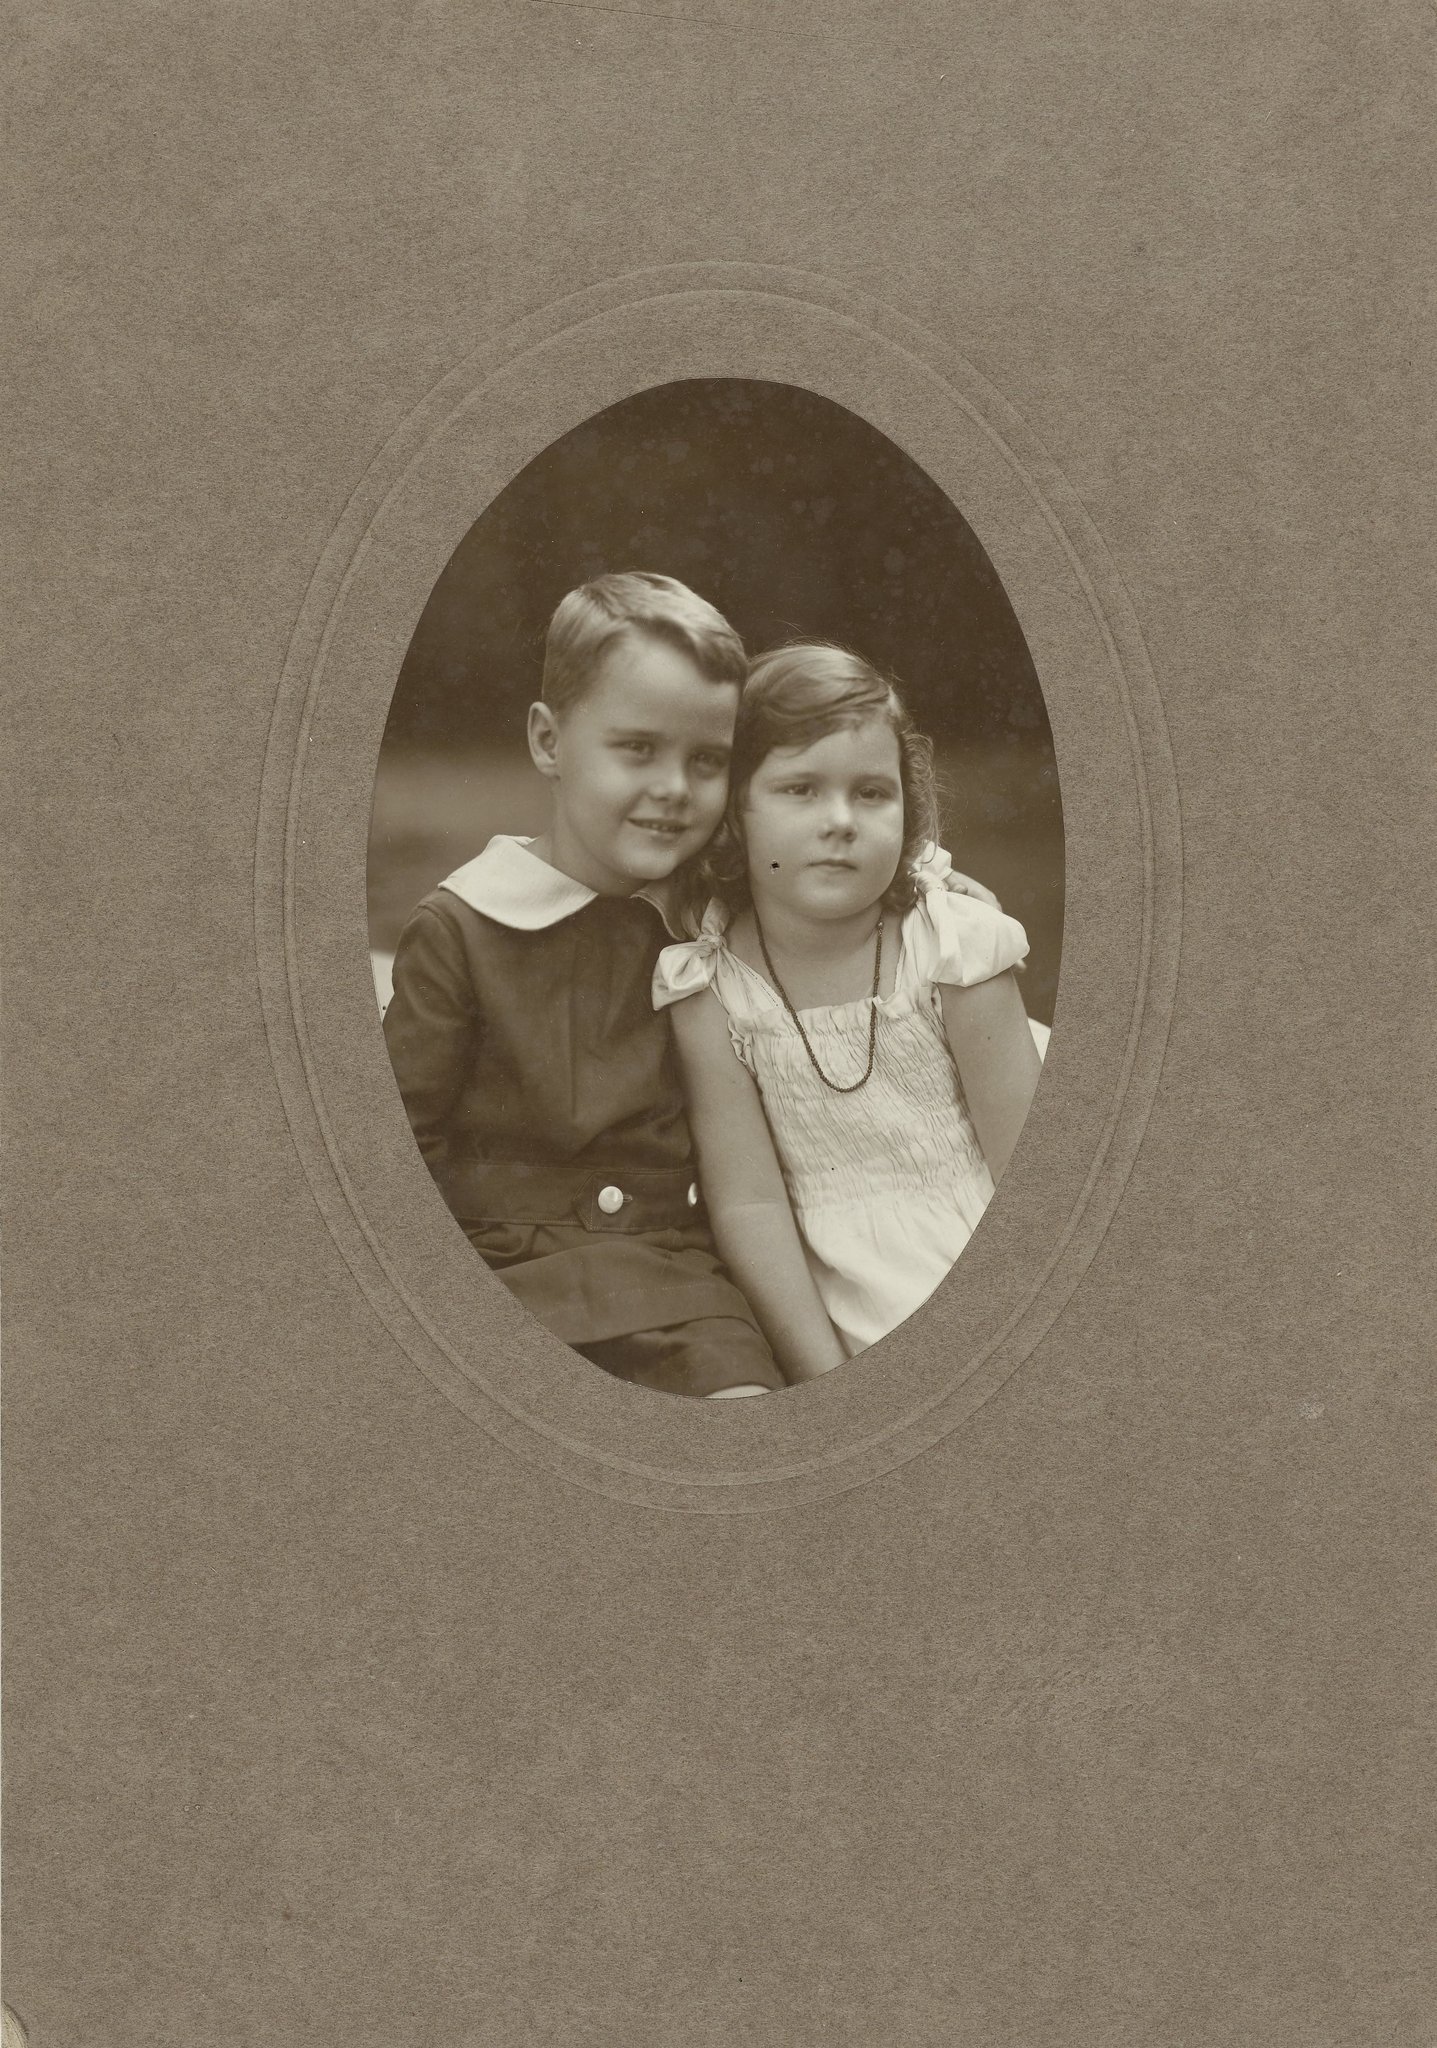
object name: photograph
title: Portret van Klaas en Tiny Vermeulen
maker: Anonymous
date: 1918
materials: cardboard, photographic support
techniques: gelatin silver print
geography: borneo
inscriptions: inscription: ‘Met heel veel kusjes van Klaasje en Tineke voor Tante Paul en Oom Bram’